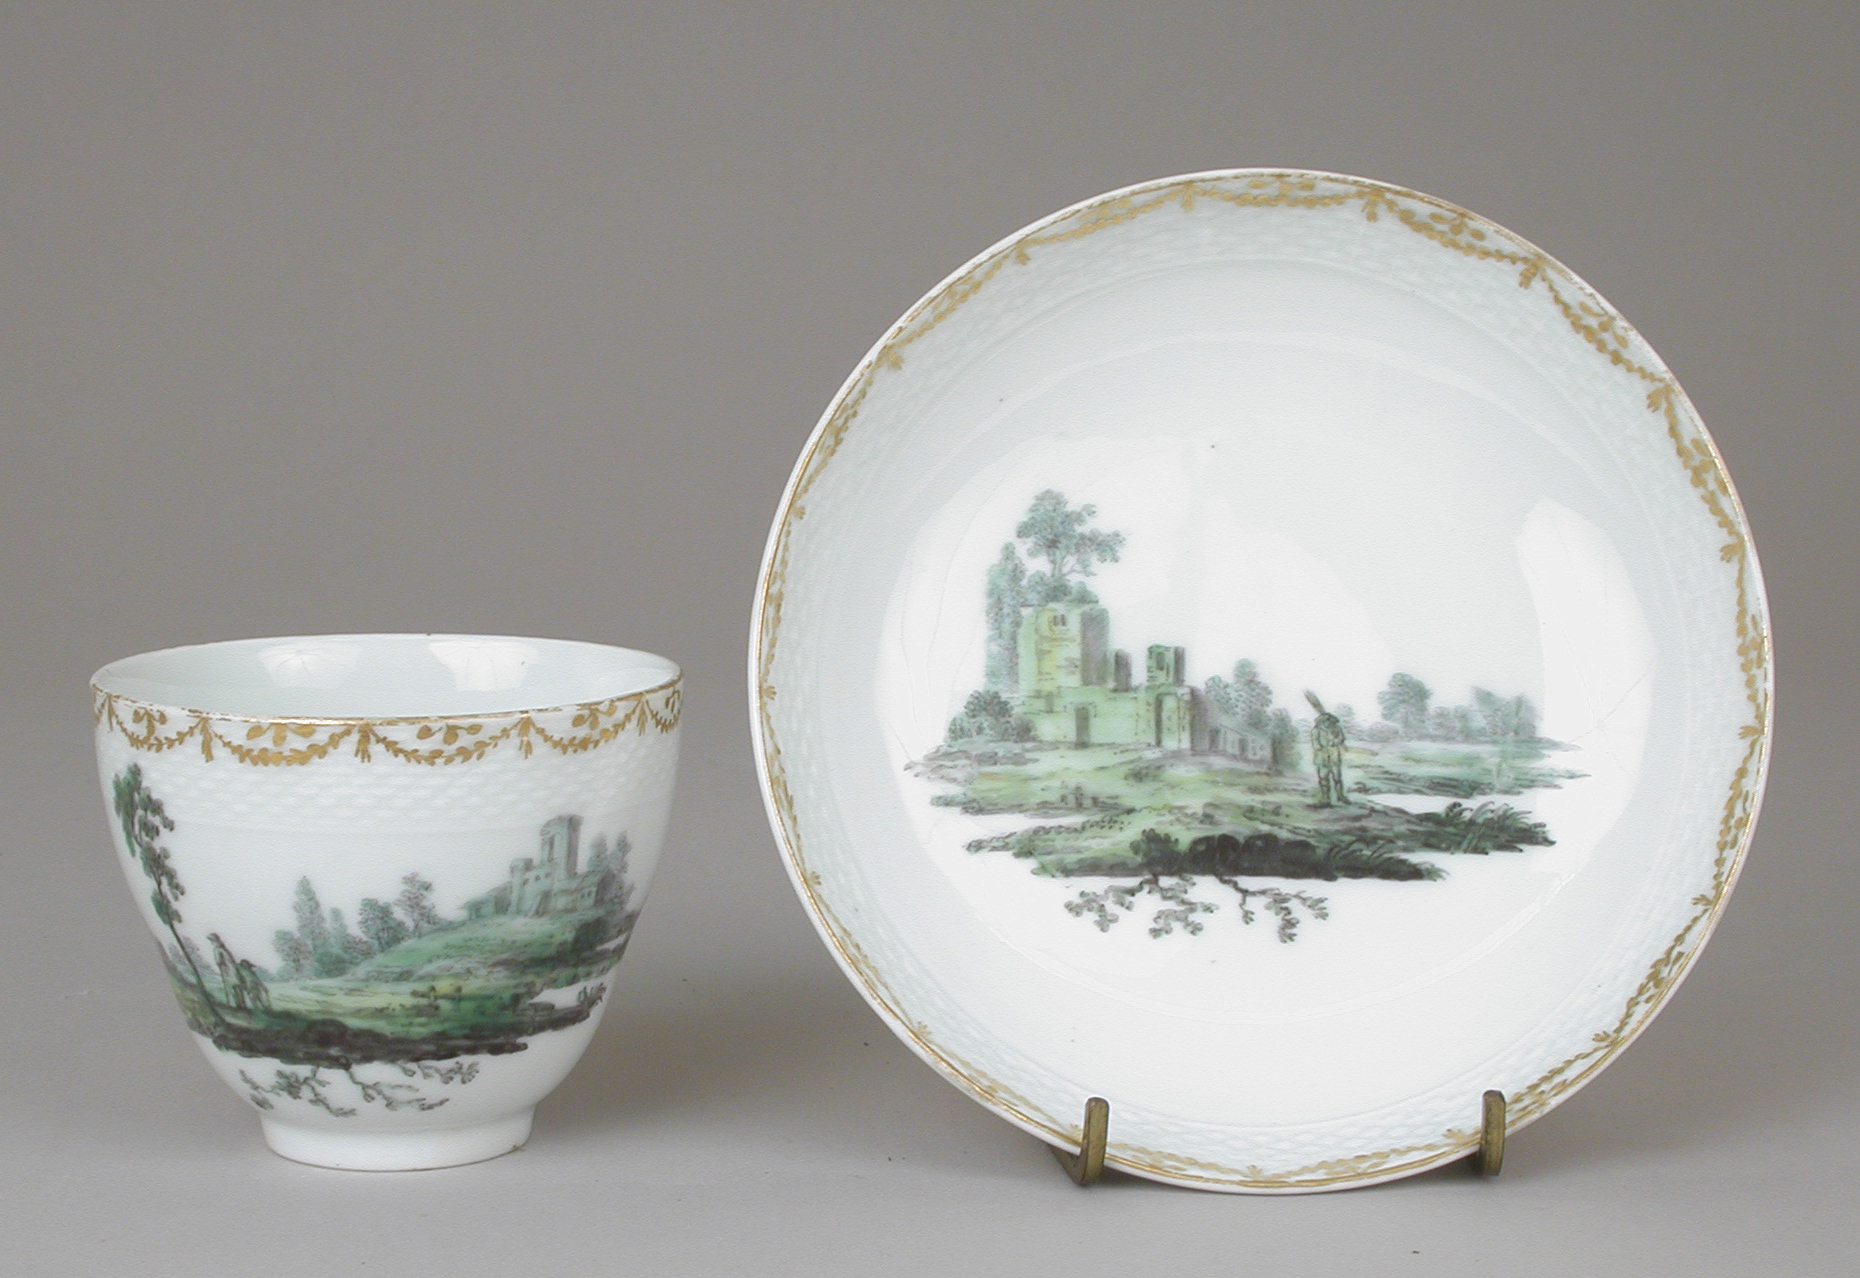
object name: cup and saucer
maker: royal porcelain manufactory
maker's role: factory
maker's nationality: danish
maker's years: 1775-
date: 1785-1790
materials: hard paste porcelain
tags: human figures,houses,trees